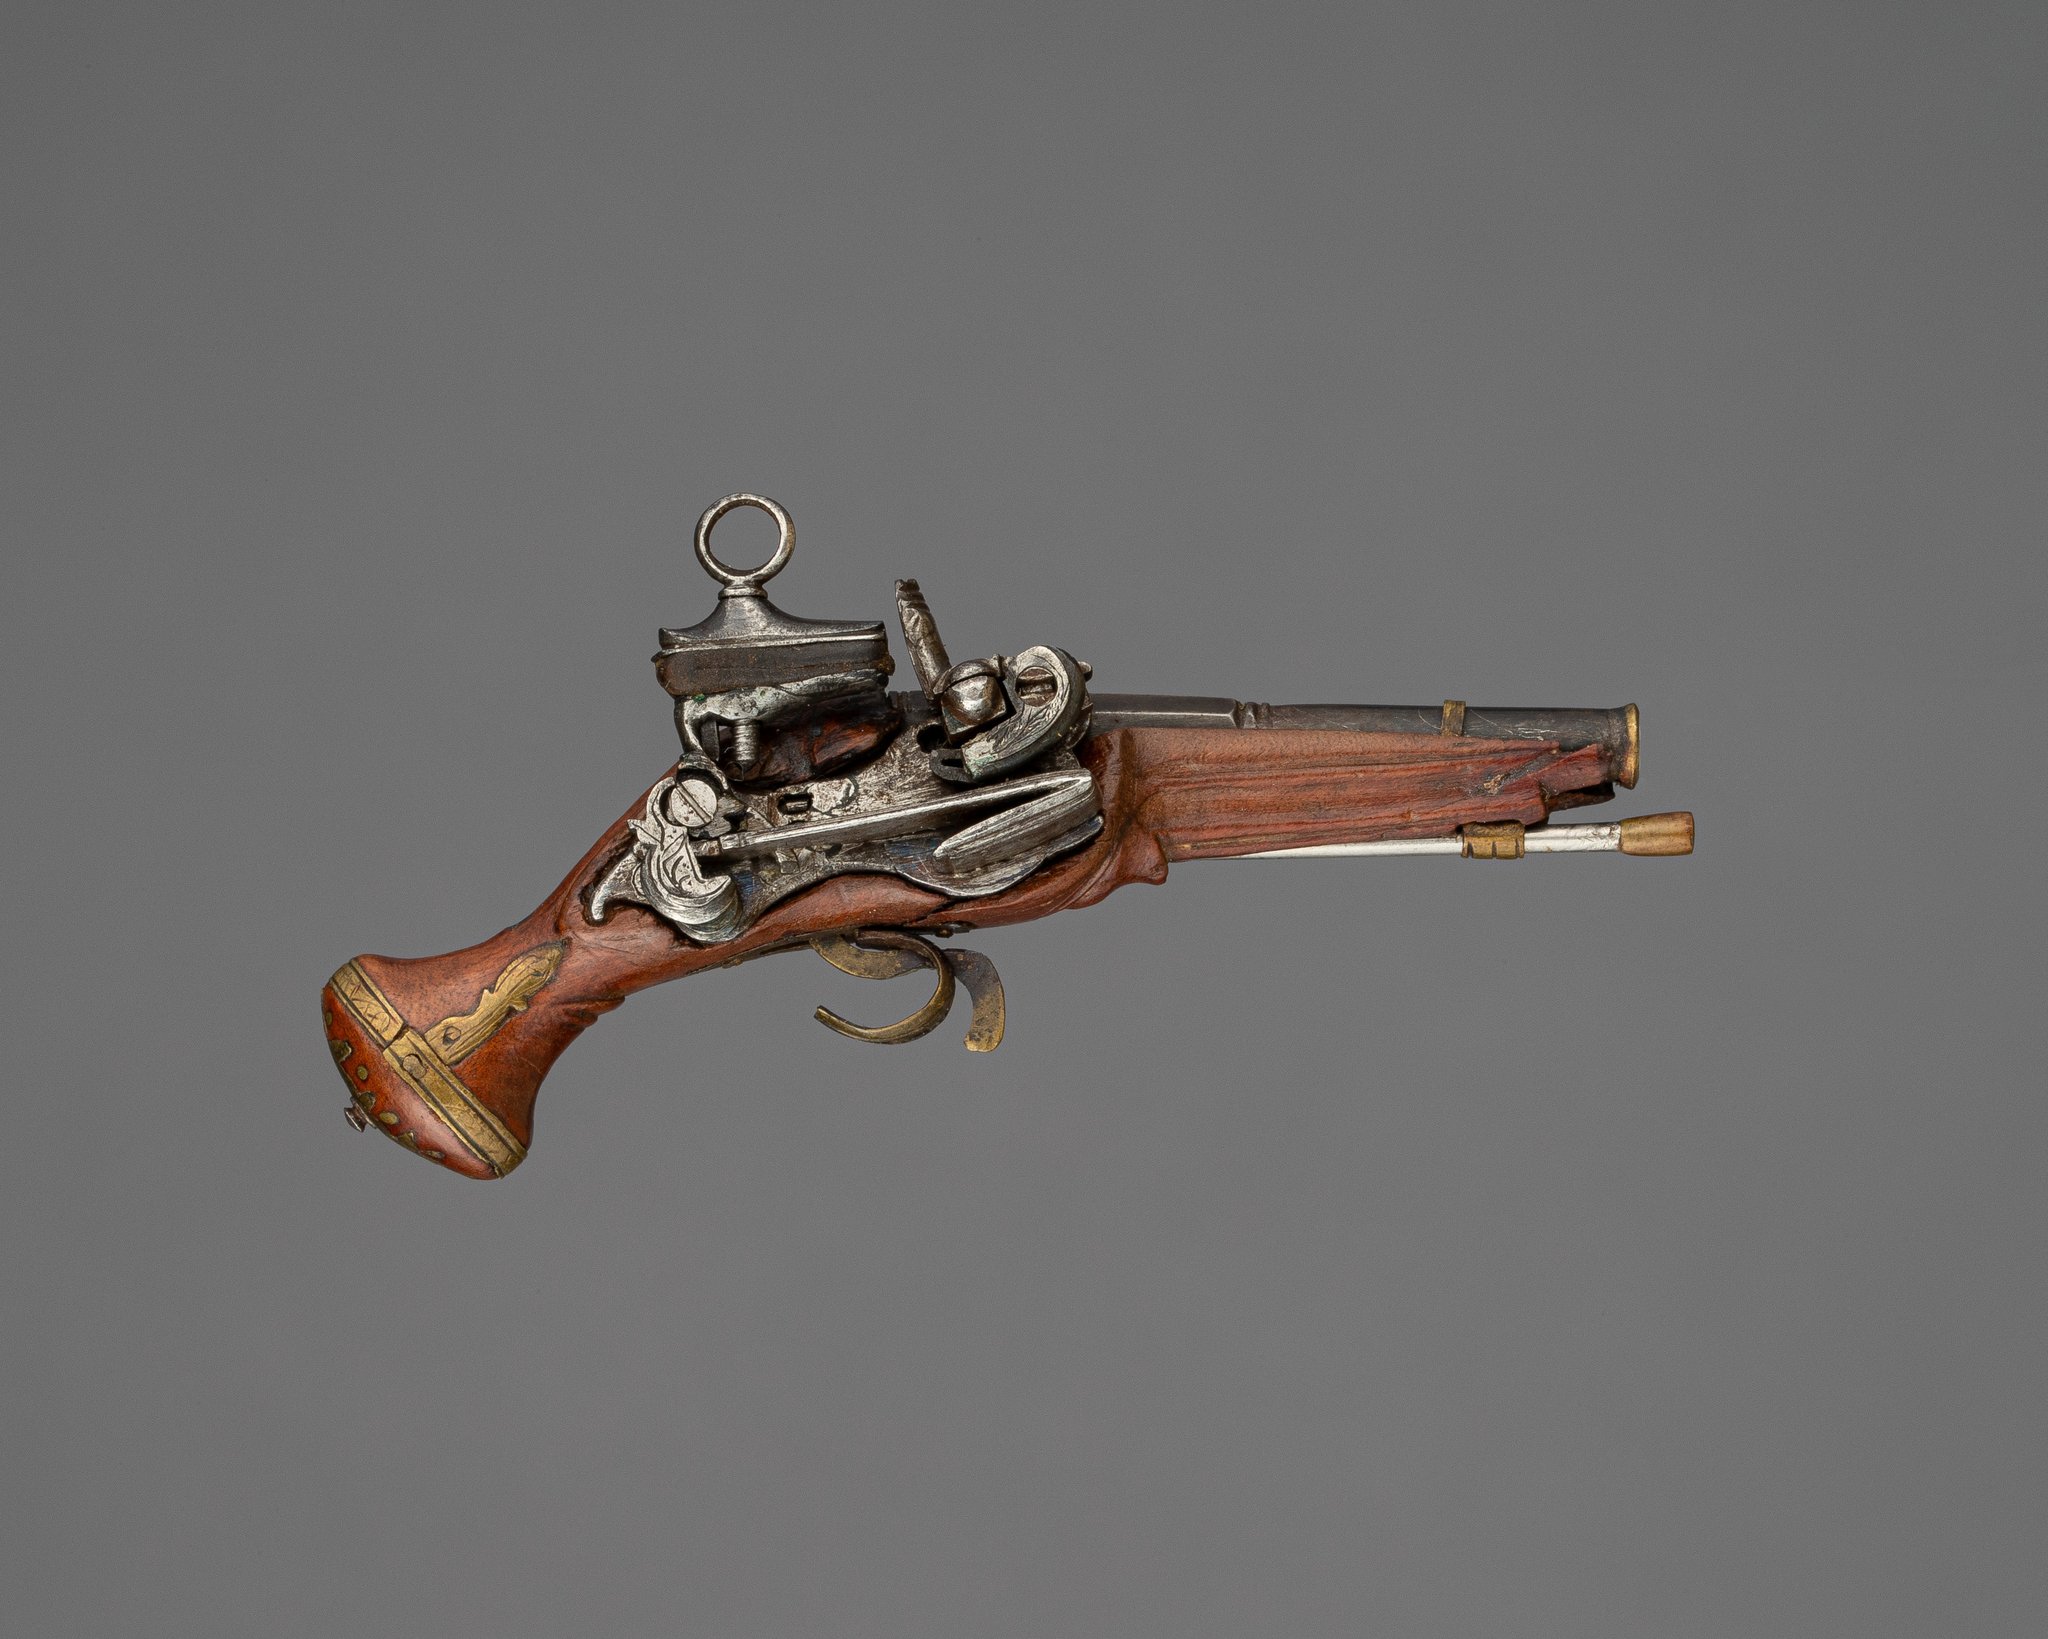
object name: model of a miquelet pistol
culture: french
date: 1601-1700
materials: brass, steel, wood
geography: france